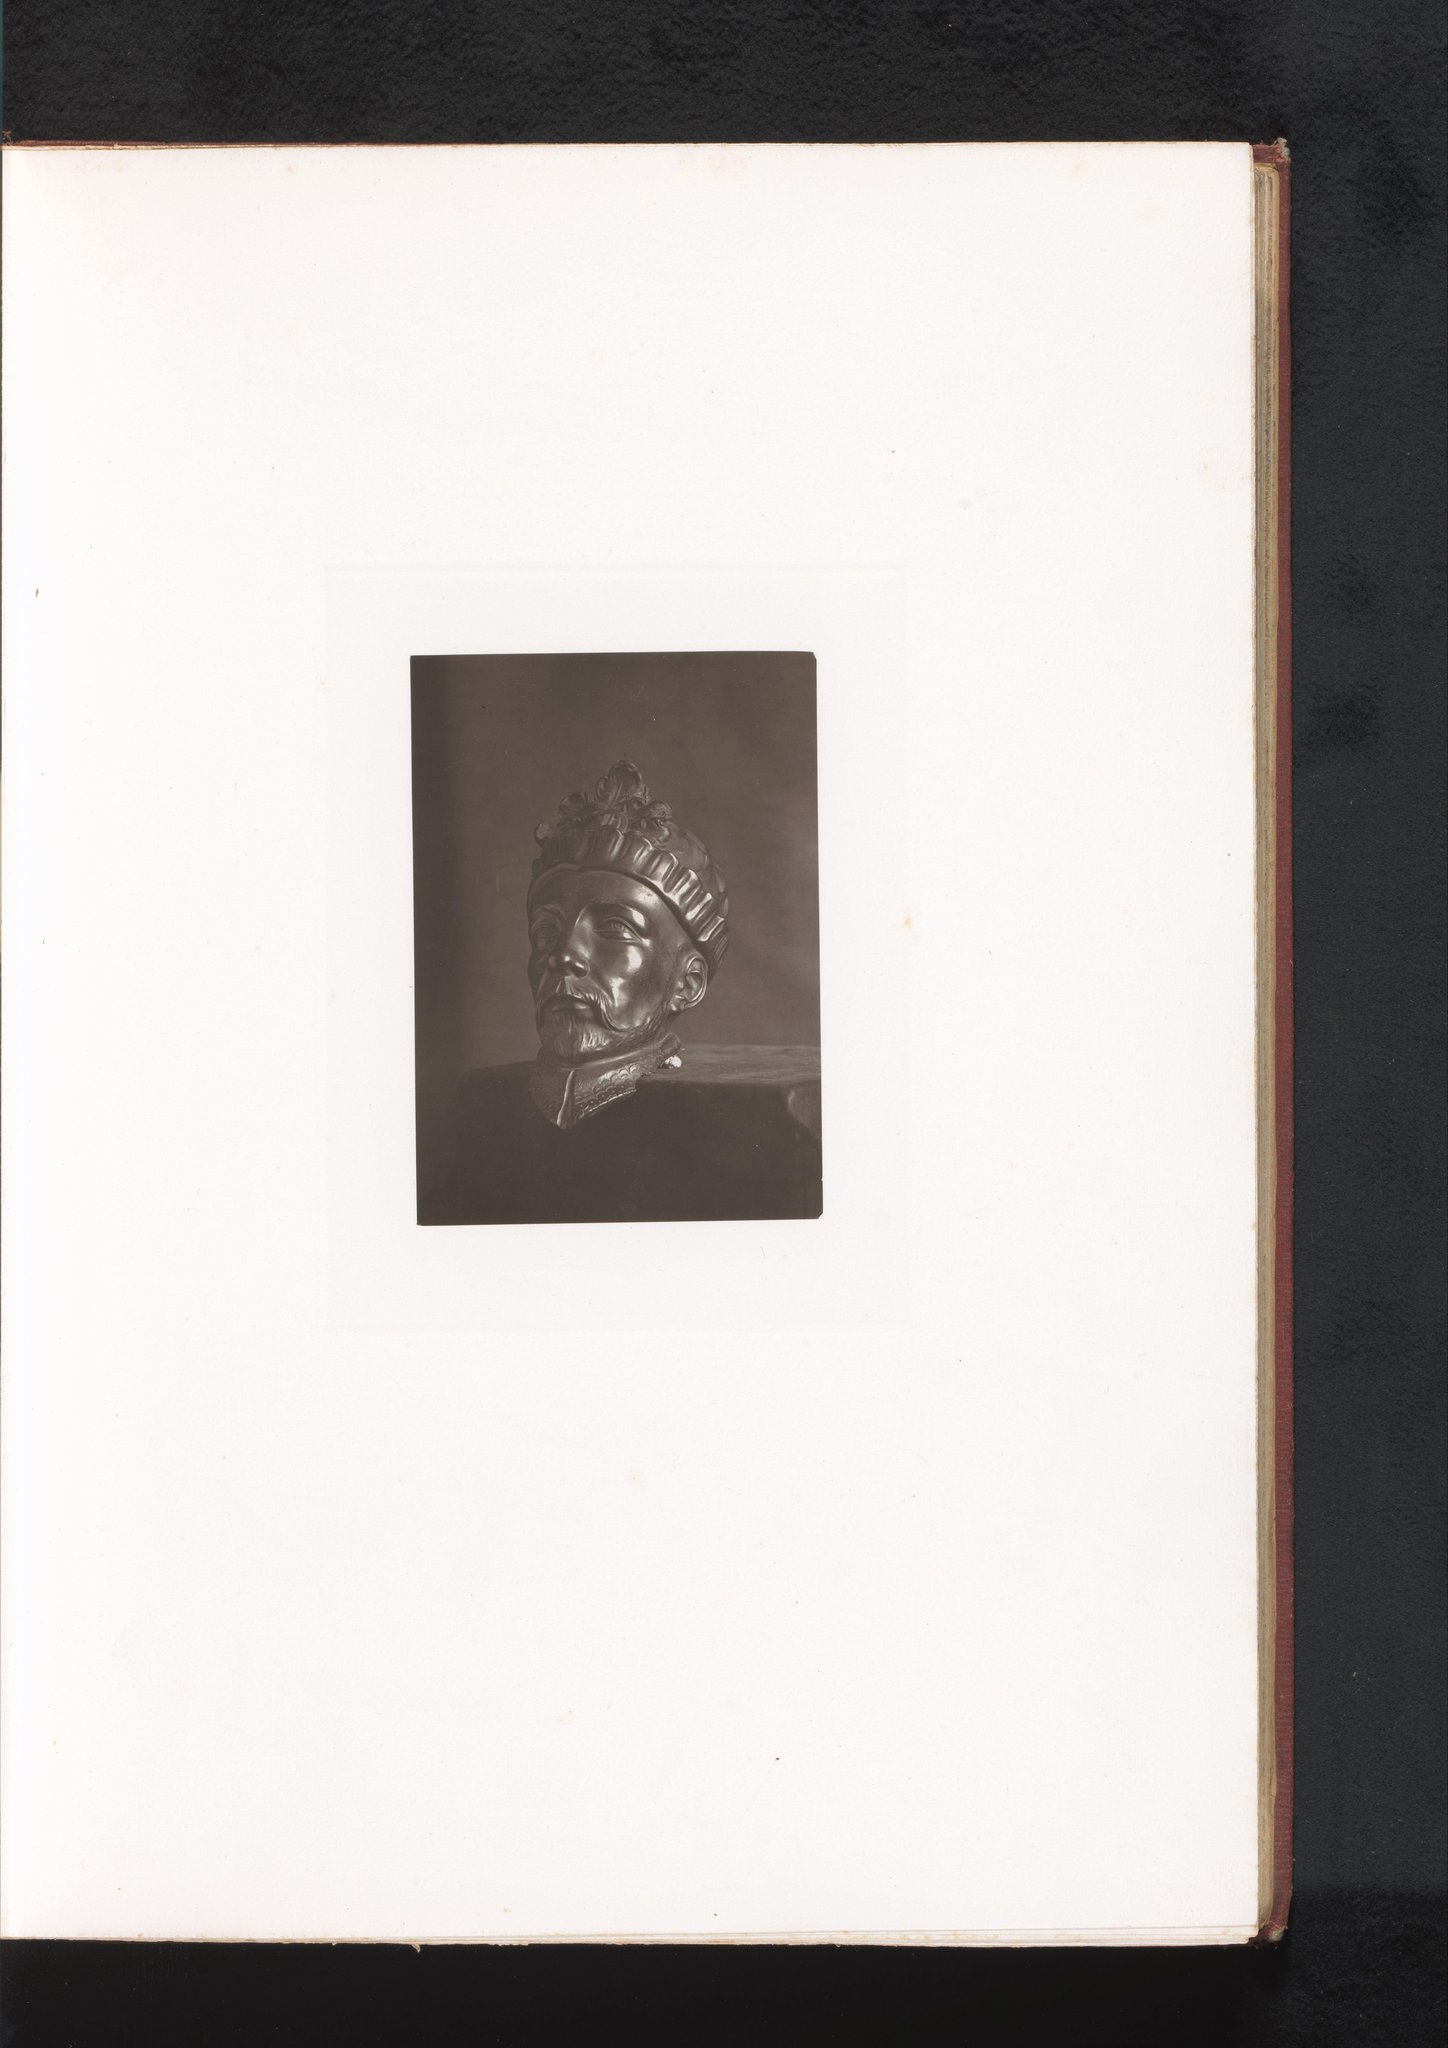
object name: page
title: Sculptuur van het hoofd van Hendrik III van Frankrijk, opgesteld tijdens de Exposition Rétrospective van 1873 in Tours, Frankrijk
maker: gabriel blaise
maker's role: printer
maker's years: 1827-1897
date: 1873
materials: paper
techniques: woodburytype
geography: tours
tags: hendrik iii (koning van frankrijk), head (human), piece of sculpture, reproduction of a piece of sculpture, temporary exhibition, 'salon'